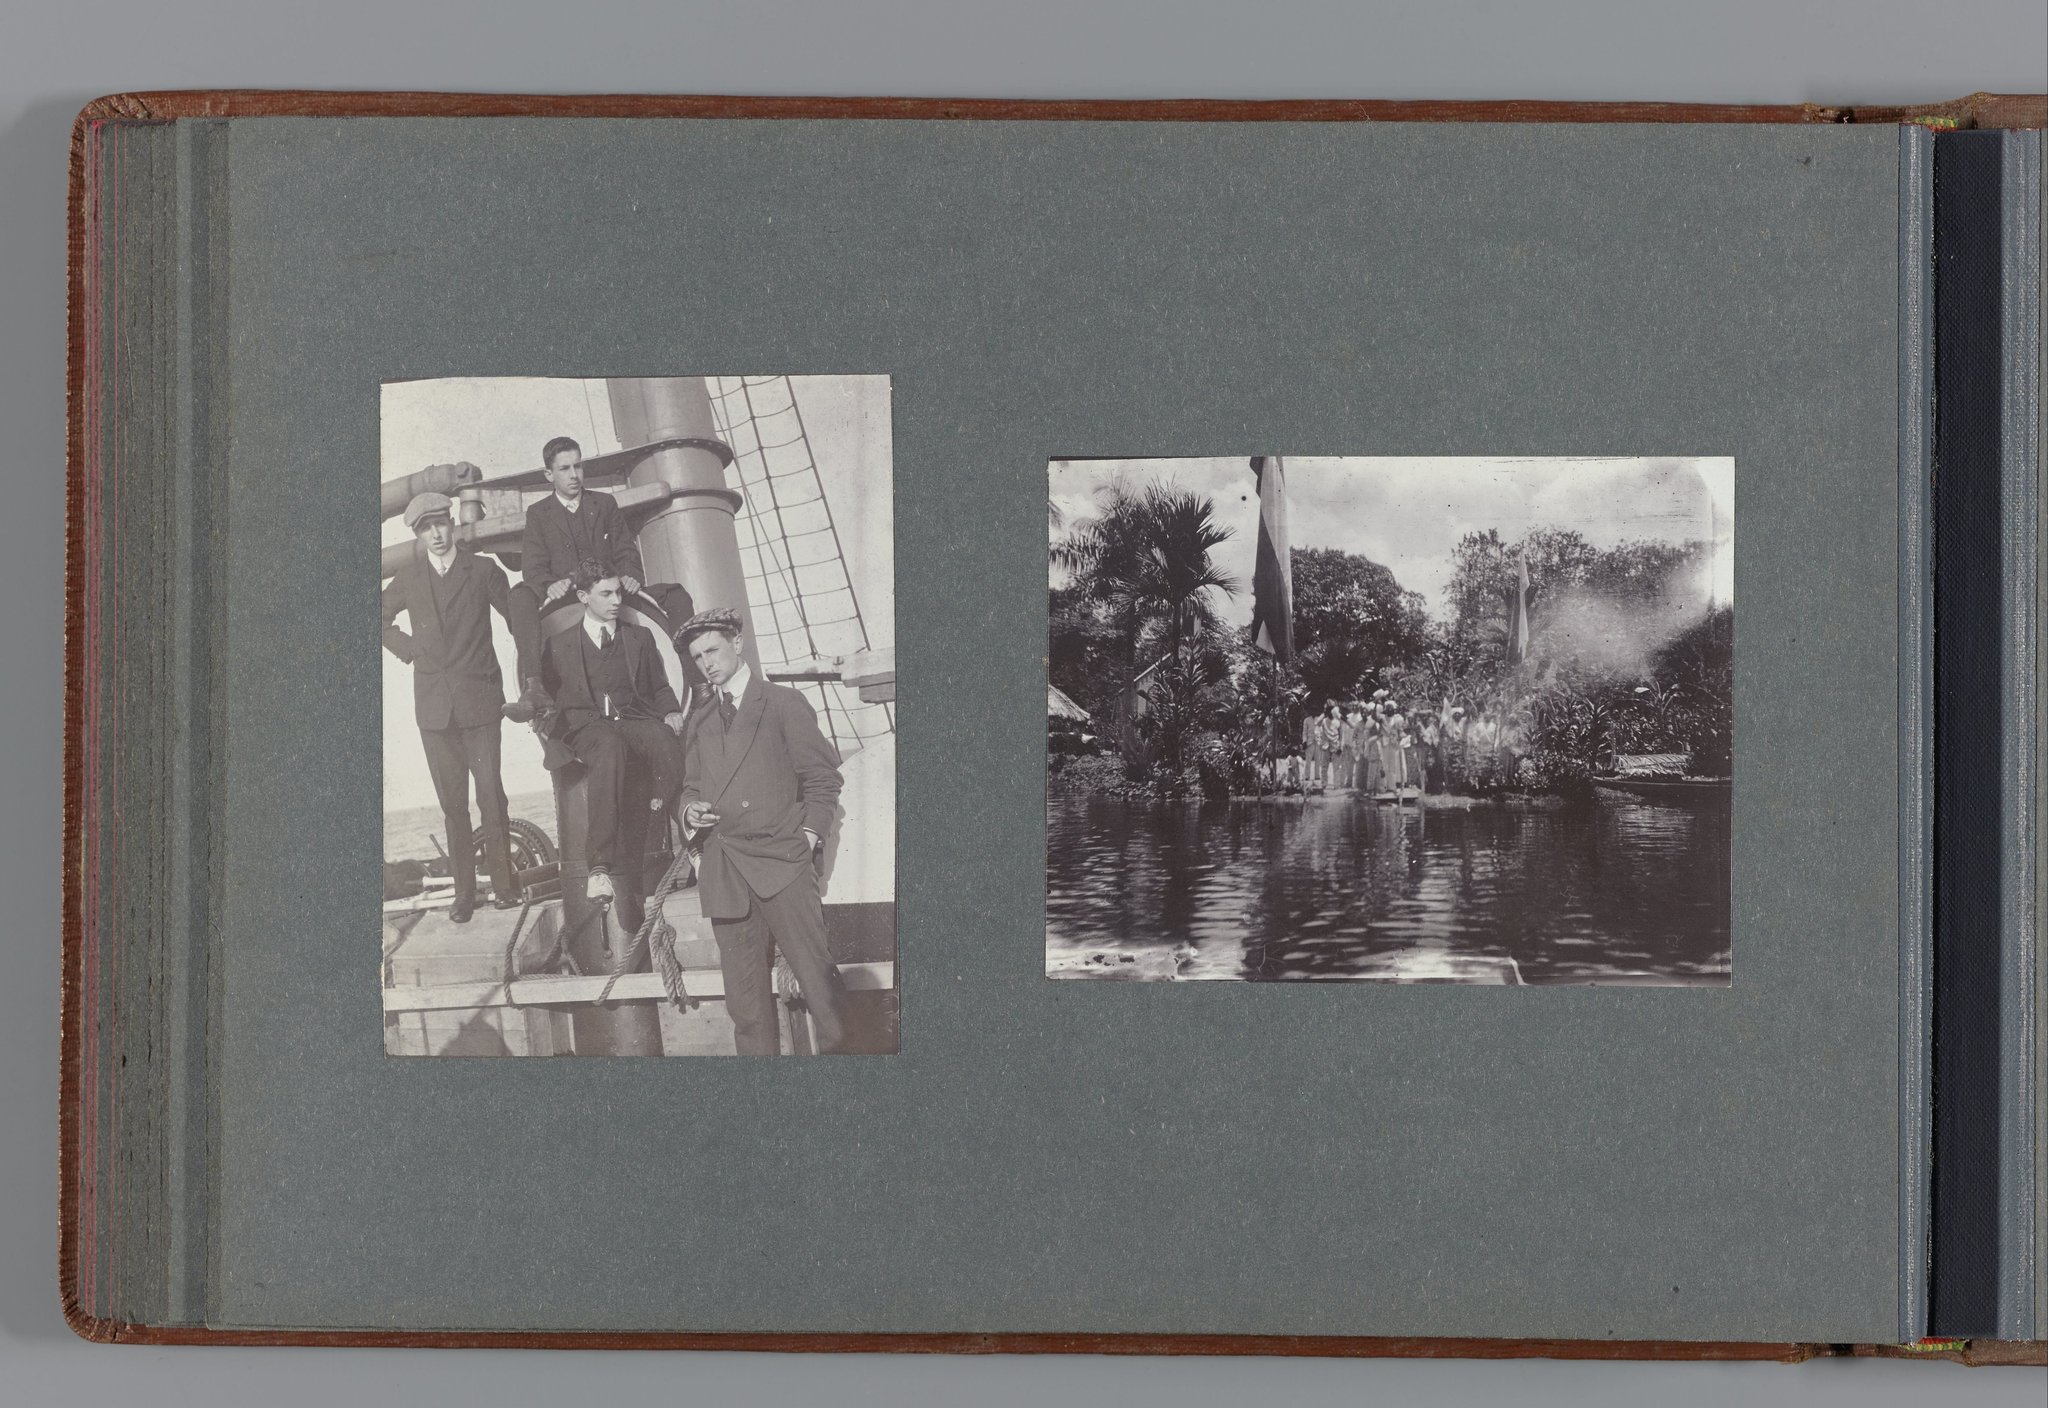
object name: photograph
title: Vier mannen staand bij de mast van een schip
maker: Anonymous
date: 1905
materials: cardboard, paper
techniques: photography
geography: paramaribo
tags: suriname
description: Vier mannen staand bij de mast van een schip. Onderdeel van fotoalbum 'Suriname'.